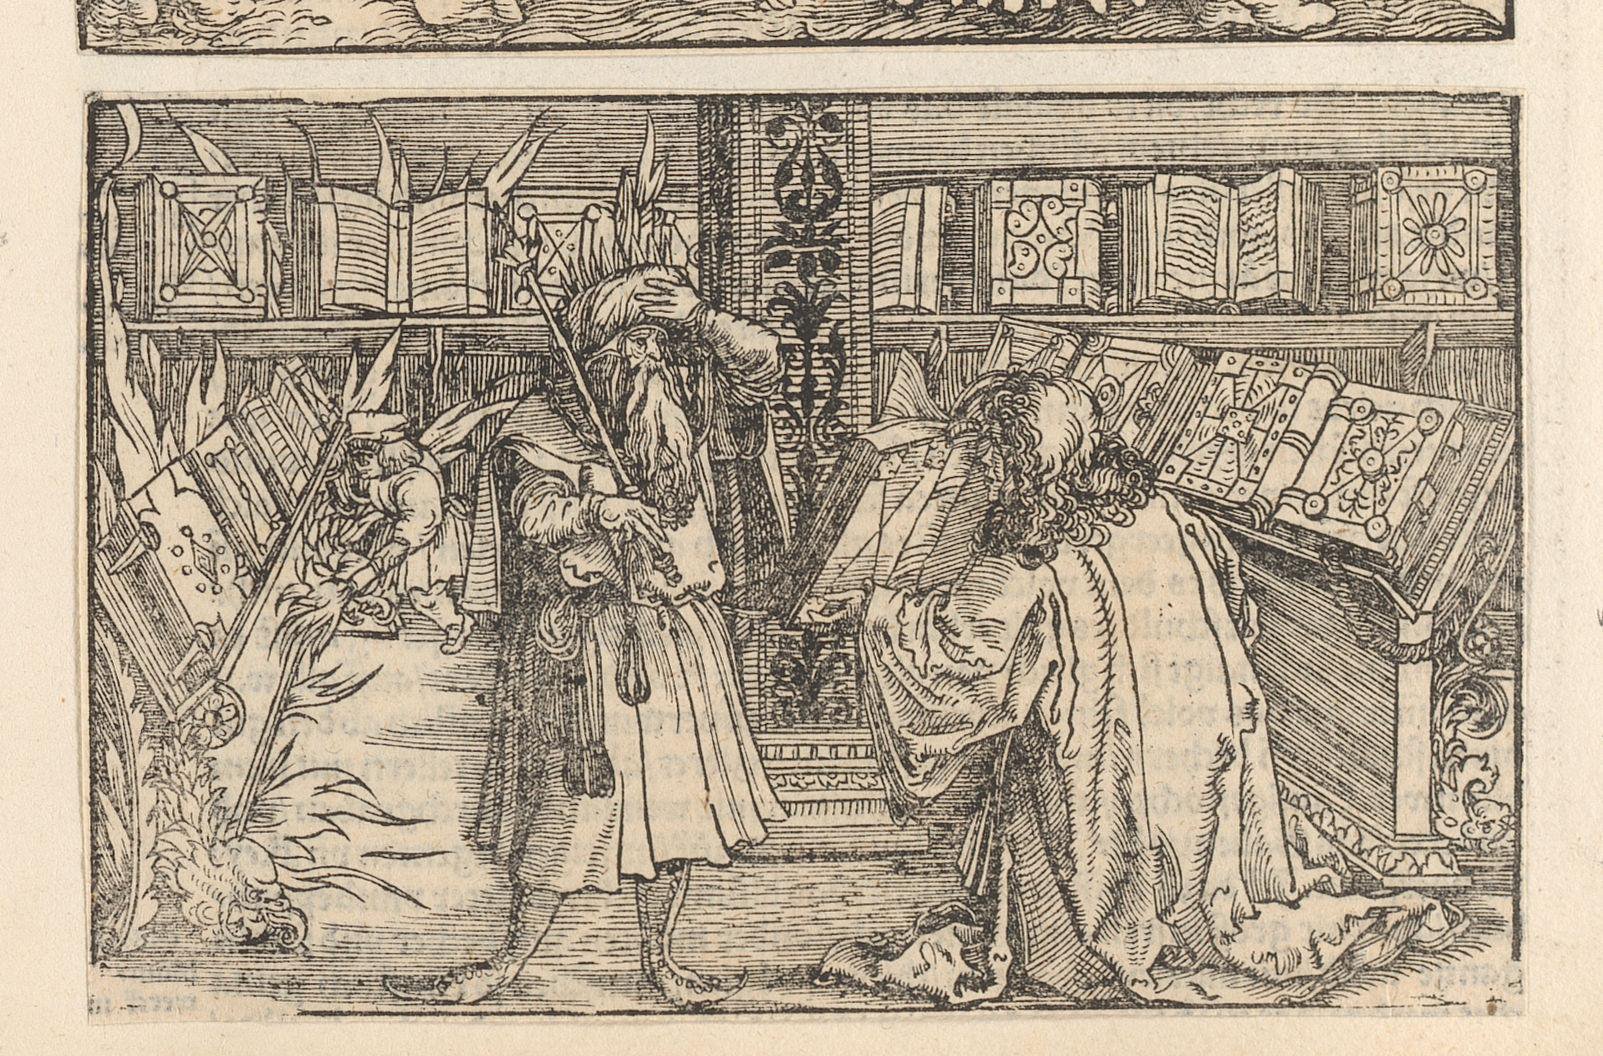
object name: album leaf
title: Heerser is overweldigd door een boek dat hem getoond wordt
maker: Anonymous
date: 1514-1532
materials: paper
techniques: letterpress printing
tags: stirring up a fire, ornament ~ candelabrum, study; 'studiolo'; library, wise men versus fools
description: Deze prent is gebruikt in: Petrarca, Francesco. Von der Artzney bayder Glück, des guten und widerwertigen: unnd weß sich ain yeder inn Gelück und Unglück halten sol (...). Augsburg: Heinrich Steiner, 1532. Deze uitgave is ook bekend onder de titel 'Trostspiegel in Glück und Unglück'.